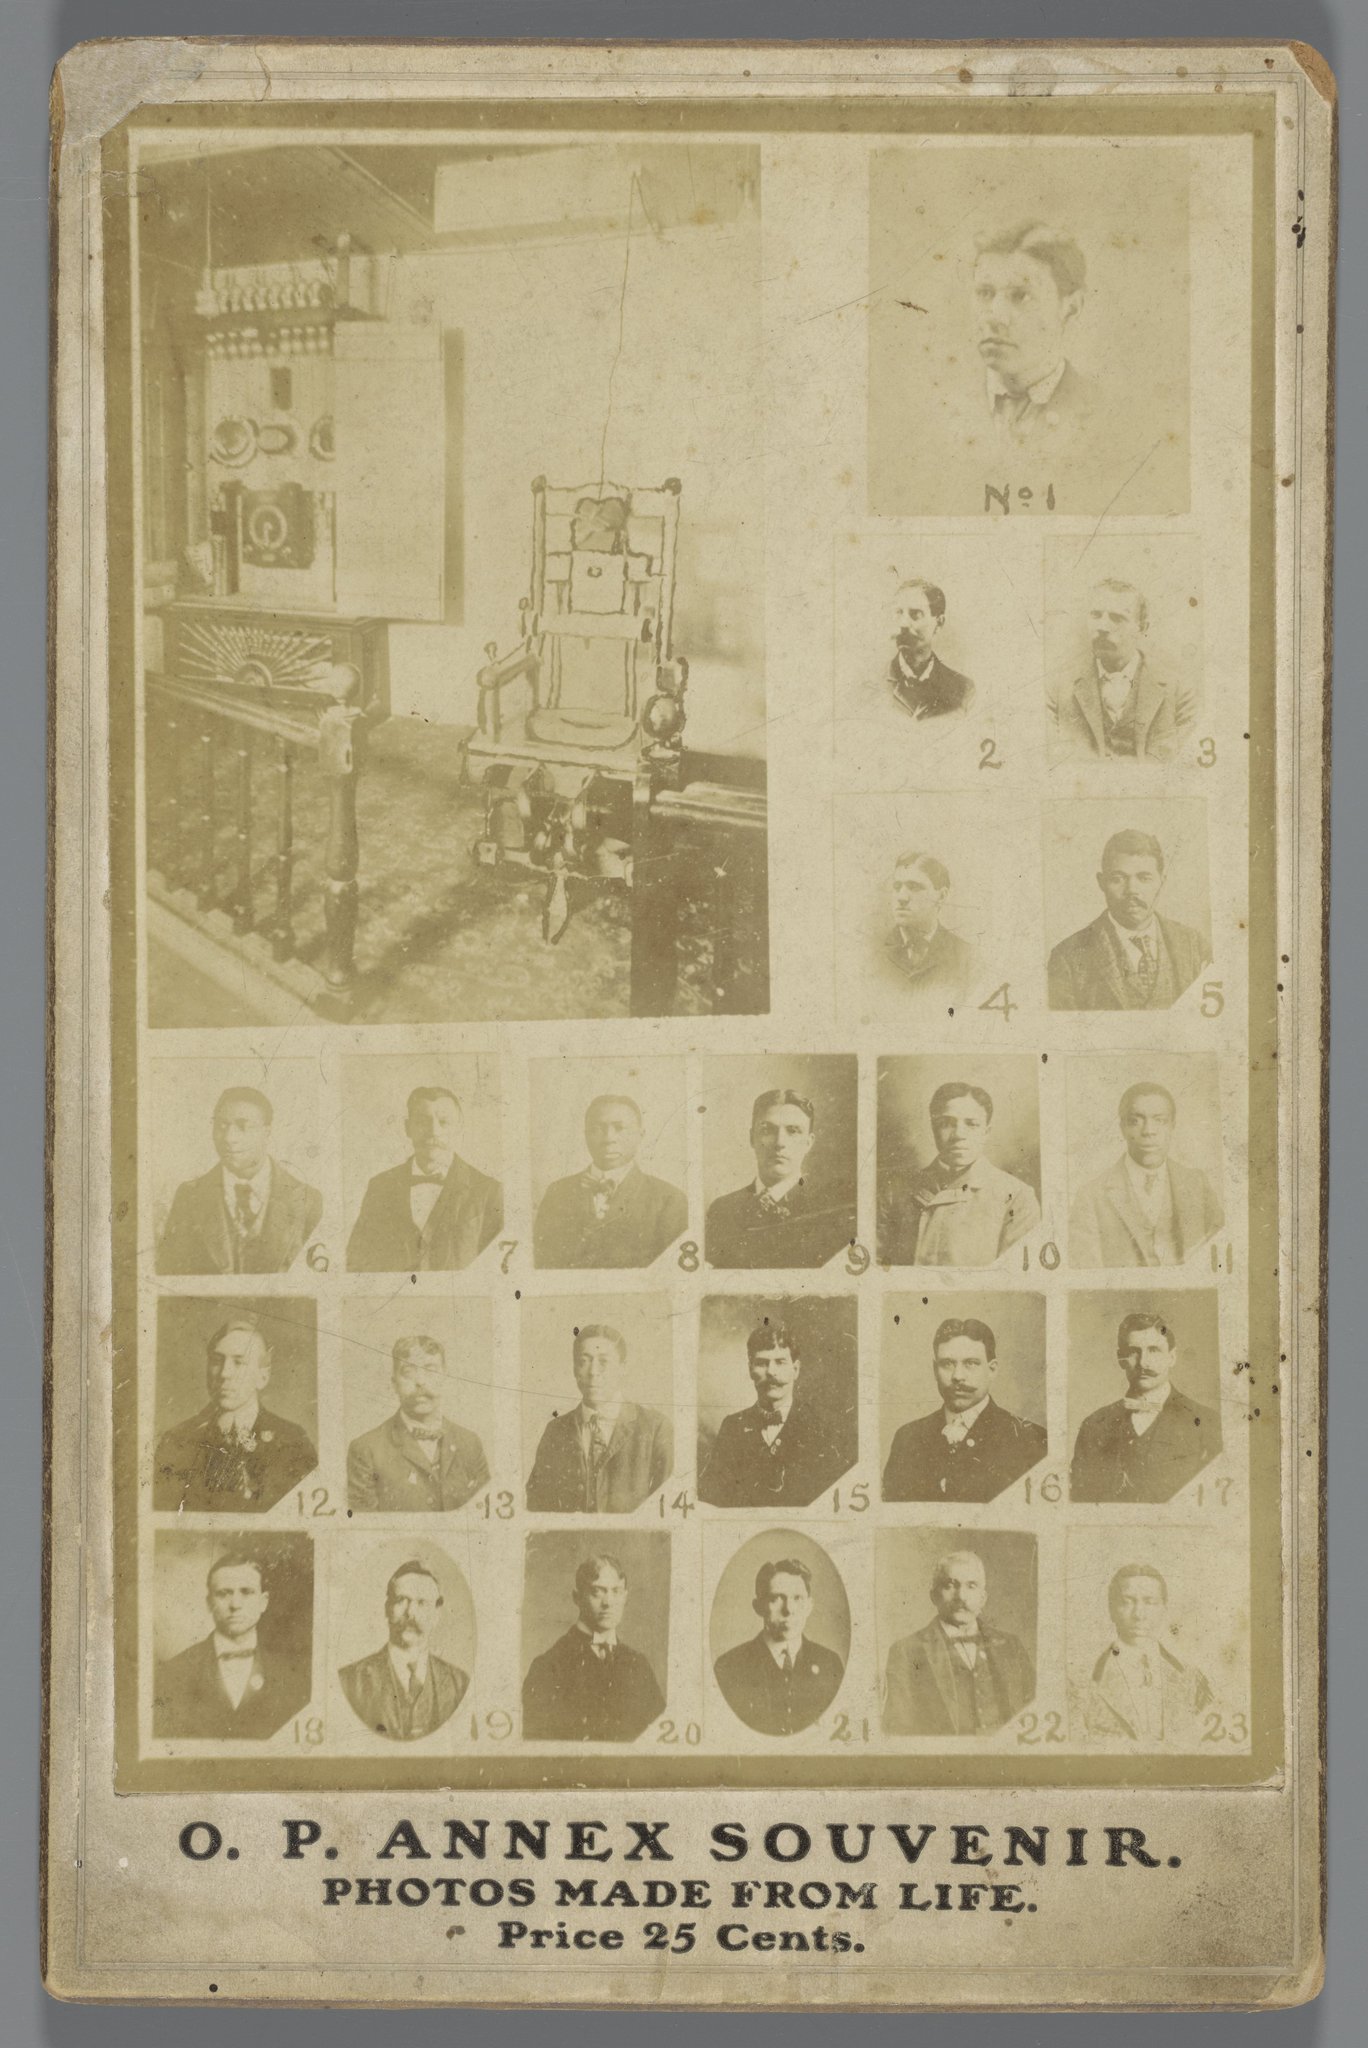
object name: cabinet photograph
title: Elektrische stoel en portretten van 23 daarop geëxecuteerde misdadigers, Ohio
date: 1905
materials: cardboard, paper, photographic support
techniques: albumen print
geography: ohio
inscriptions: annotation: ‘O. P. ANNEX SOUVENIR. / PHOTOS MADE FROM LIFE. Price 25 Cents’, annotation: ‘SOUVENIR / ELECTROCUTED: [namen van de 23 moordenaars, de namen van hun slachtoffers, en de datum van de executie]. All orders for souvenirs should / be addressed to A. T. HAZLETT. / FROM THE O. P. ANNEX, / Price, 25 Cents’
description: Op de achterzijde staan de namen van de 23 moordenaars, de namen van hun slachtoffers, en de datum van de executie.